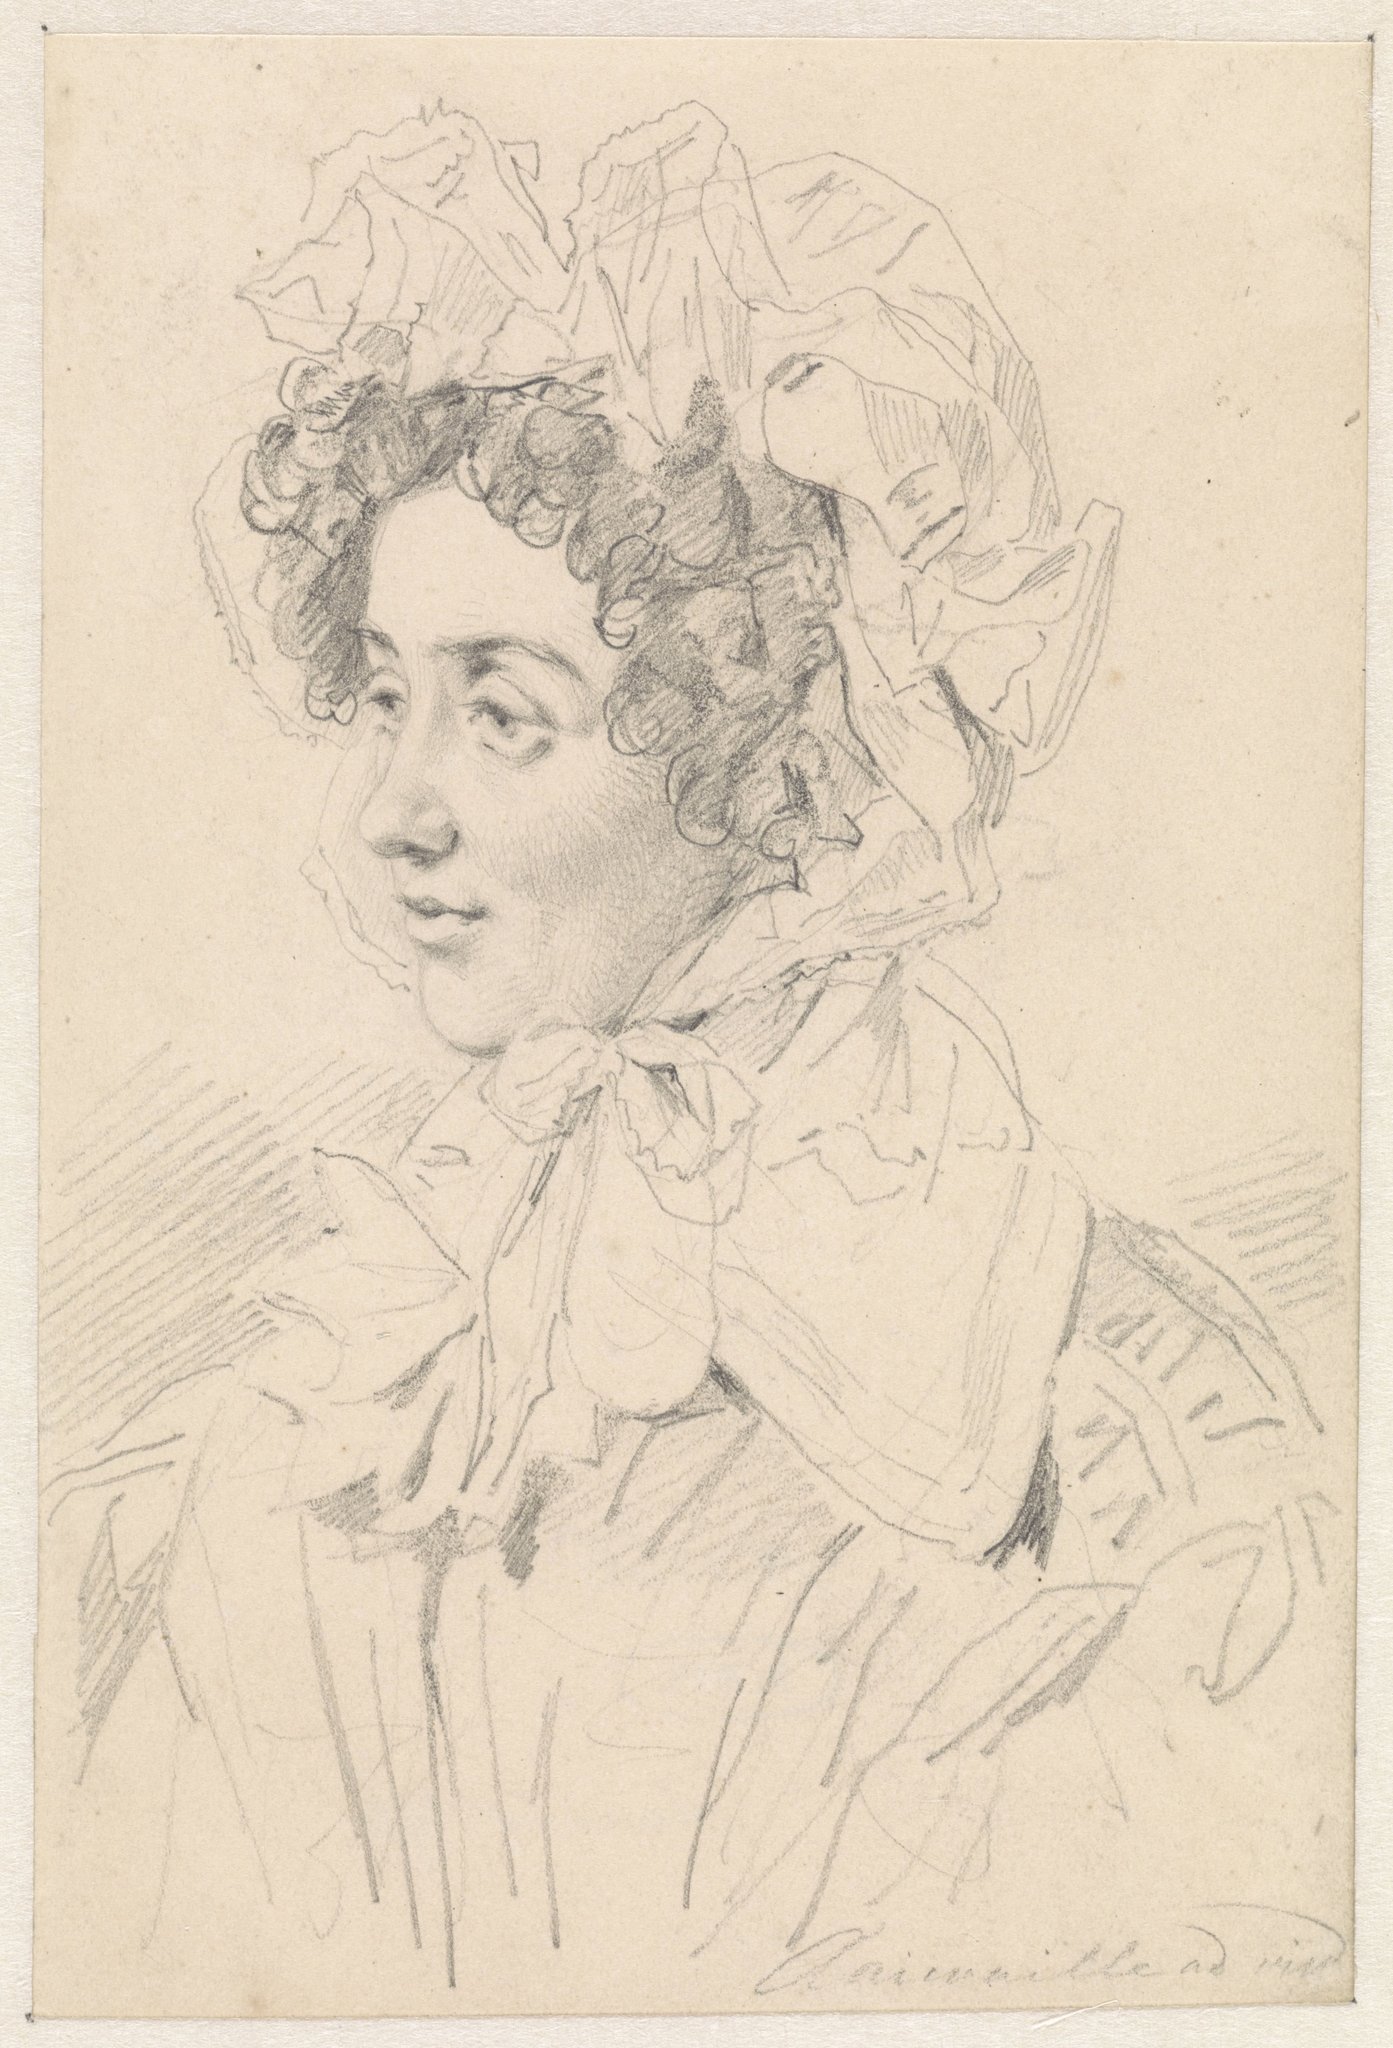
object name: drawing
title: Portret van een dame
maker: jean augustin daiwaille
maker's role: draughtsman, print maker, printer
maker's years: 1786-1850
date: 1796-1850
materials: chalk, paper, pencil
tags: anonymous historical person portrayed alone